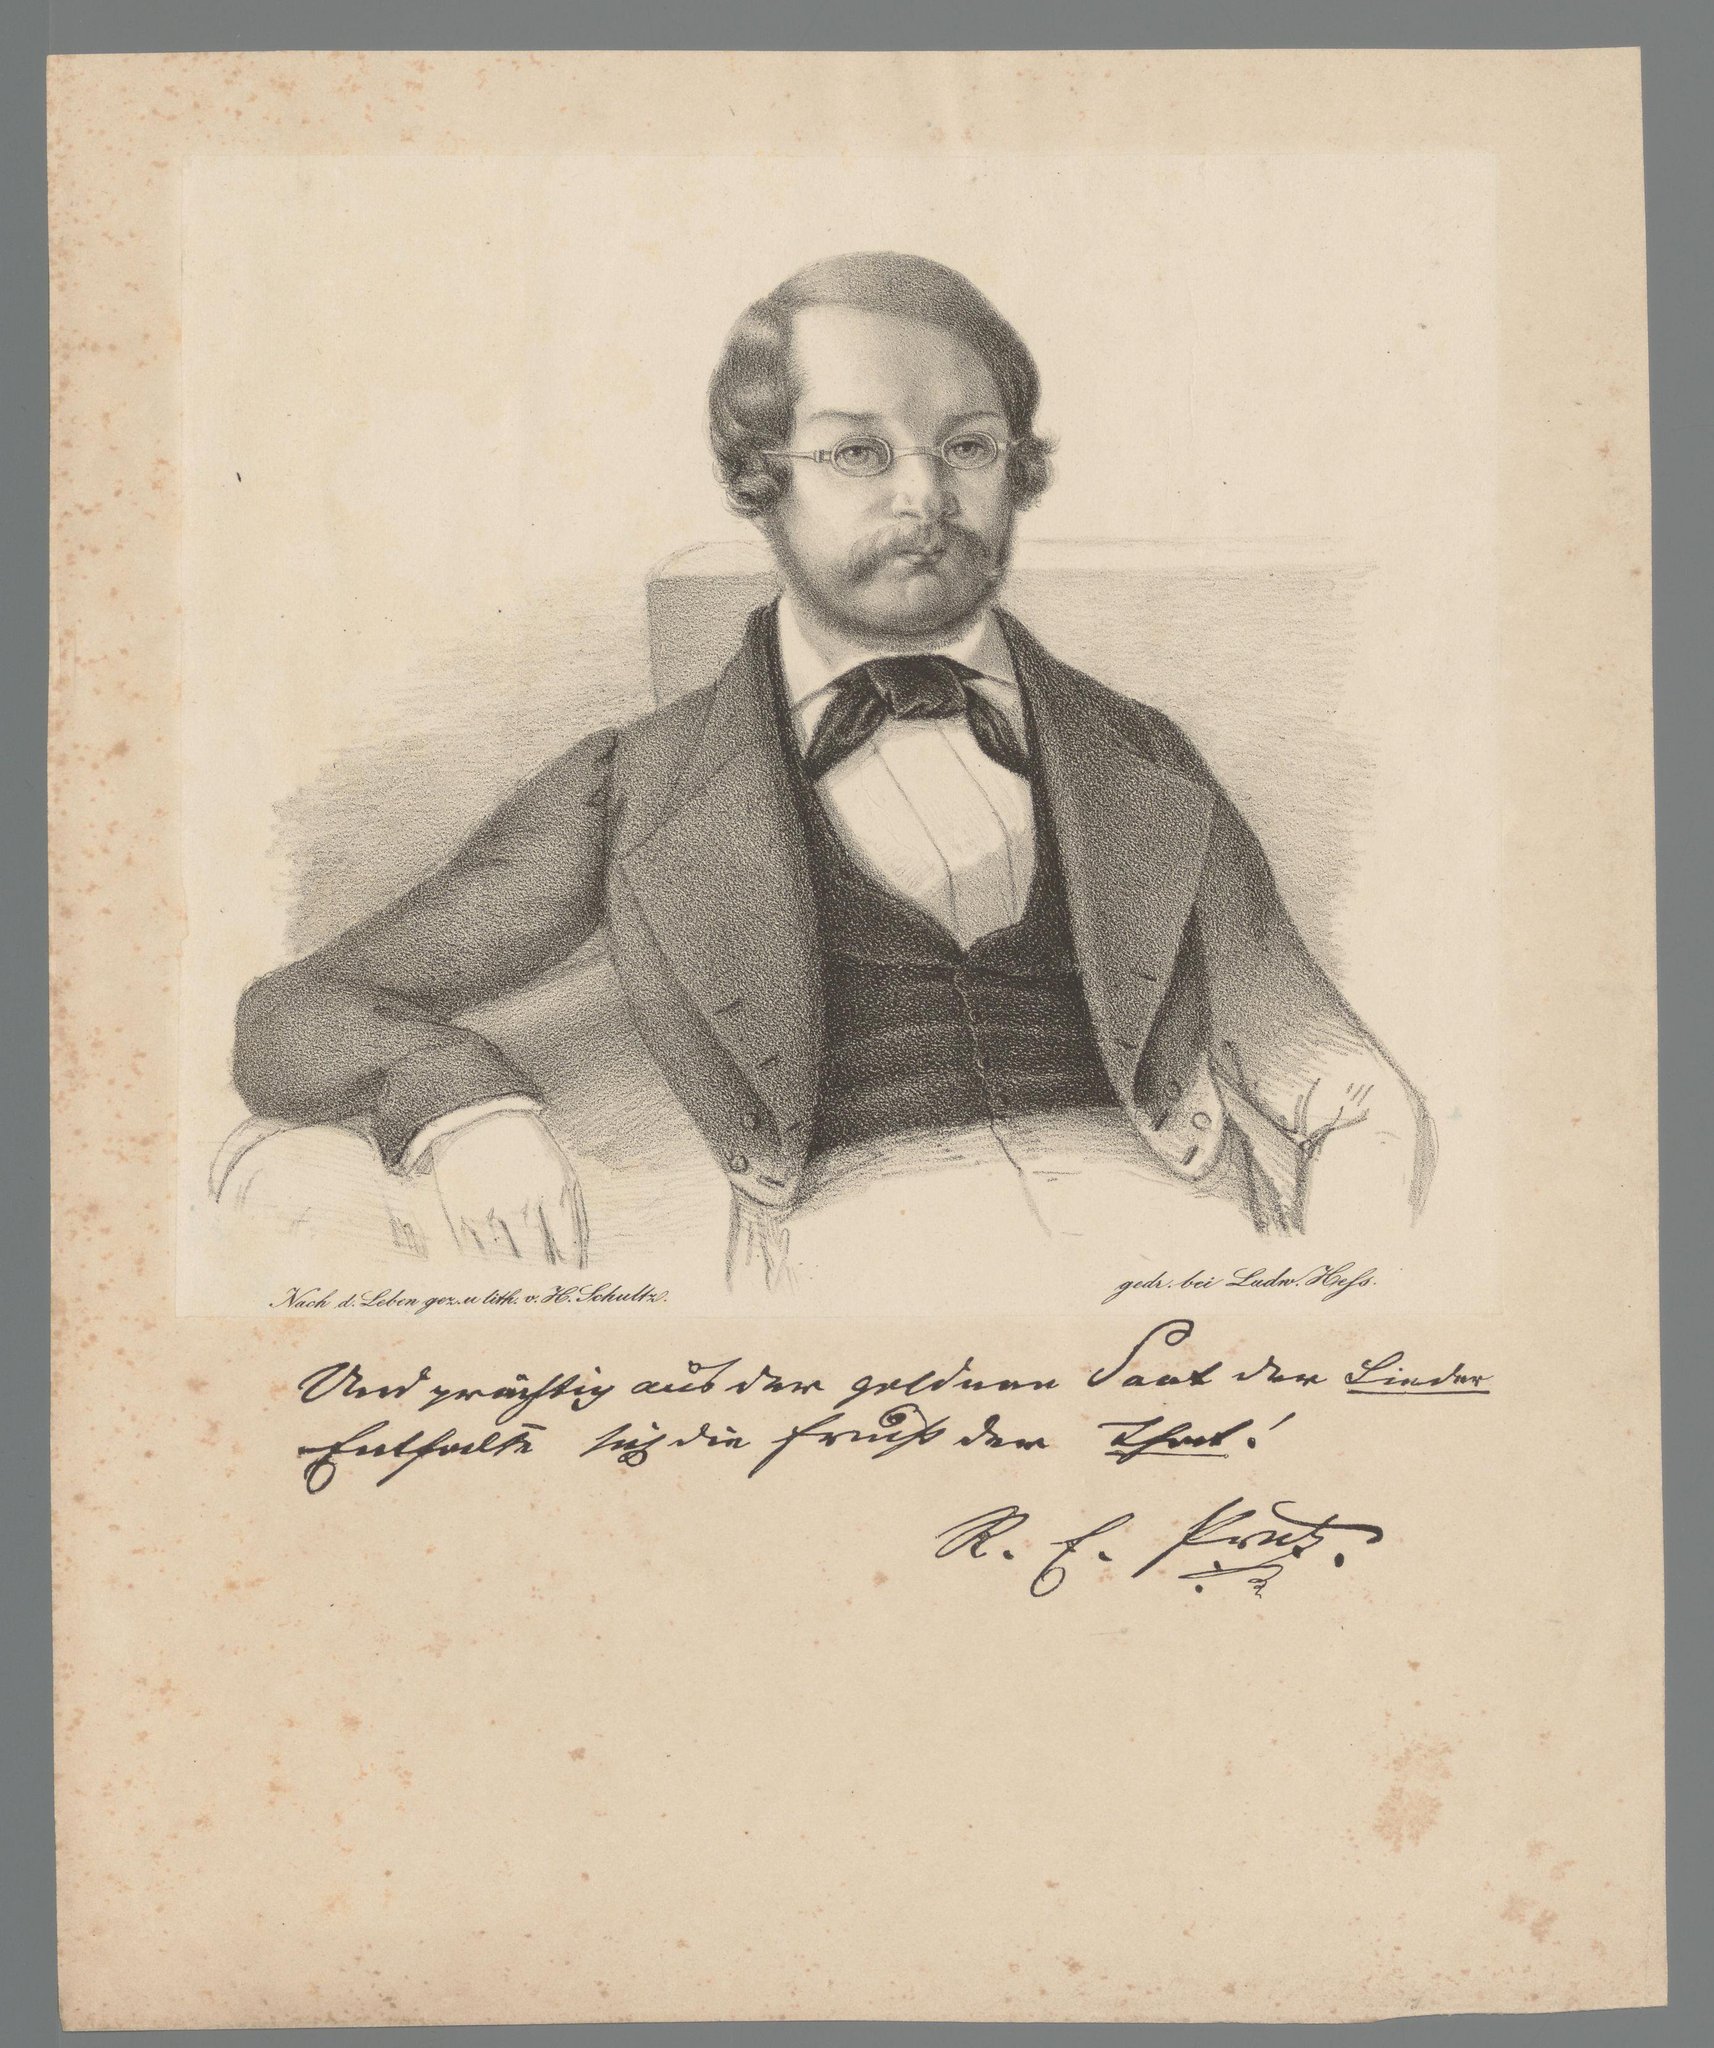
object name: print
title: Portret van Robert Prutz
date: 1770-1800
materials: paper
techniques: lithograph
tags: historical persons, portrait of a writer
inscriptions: collector's mark: Lugt 2228